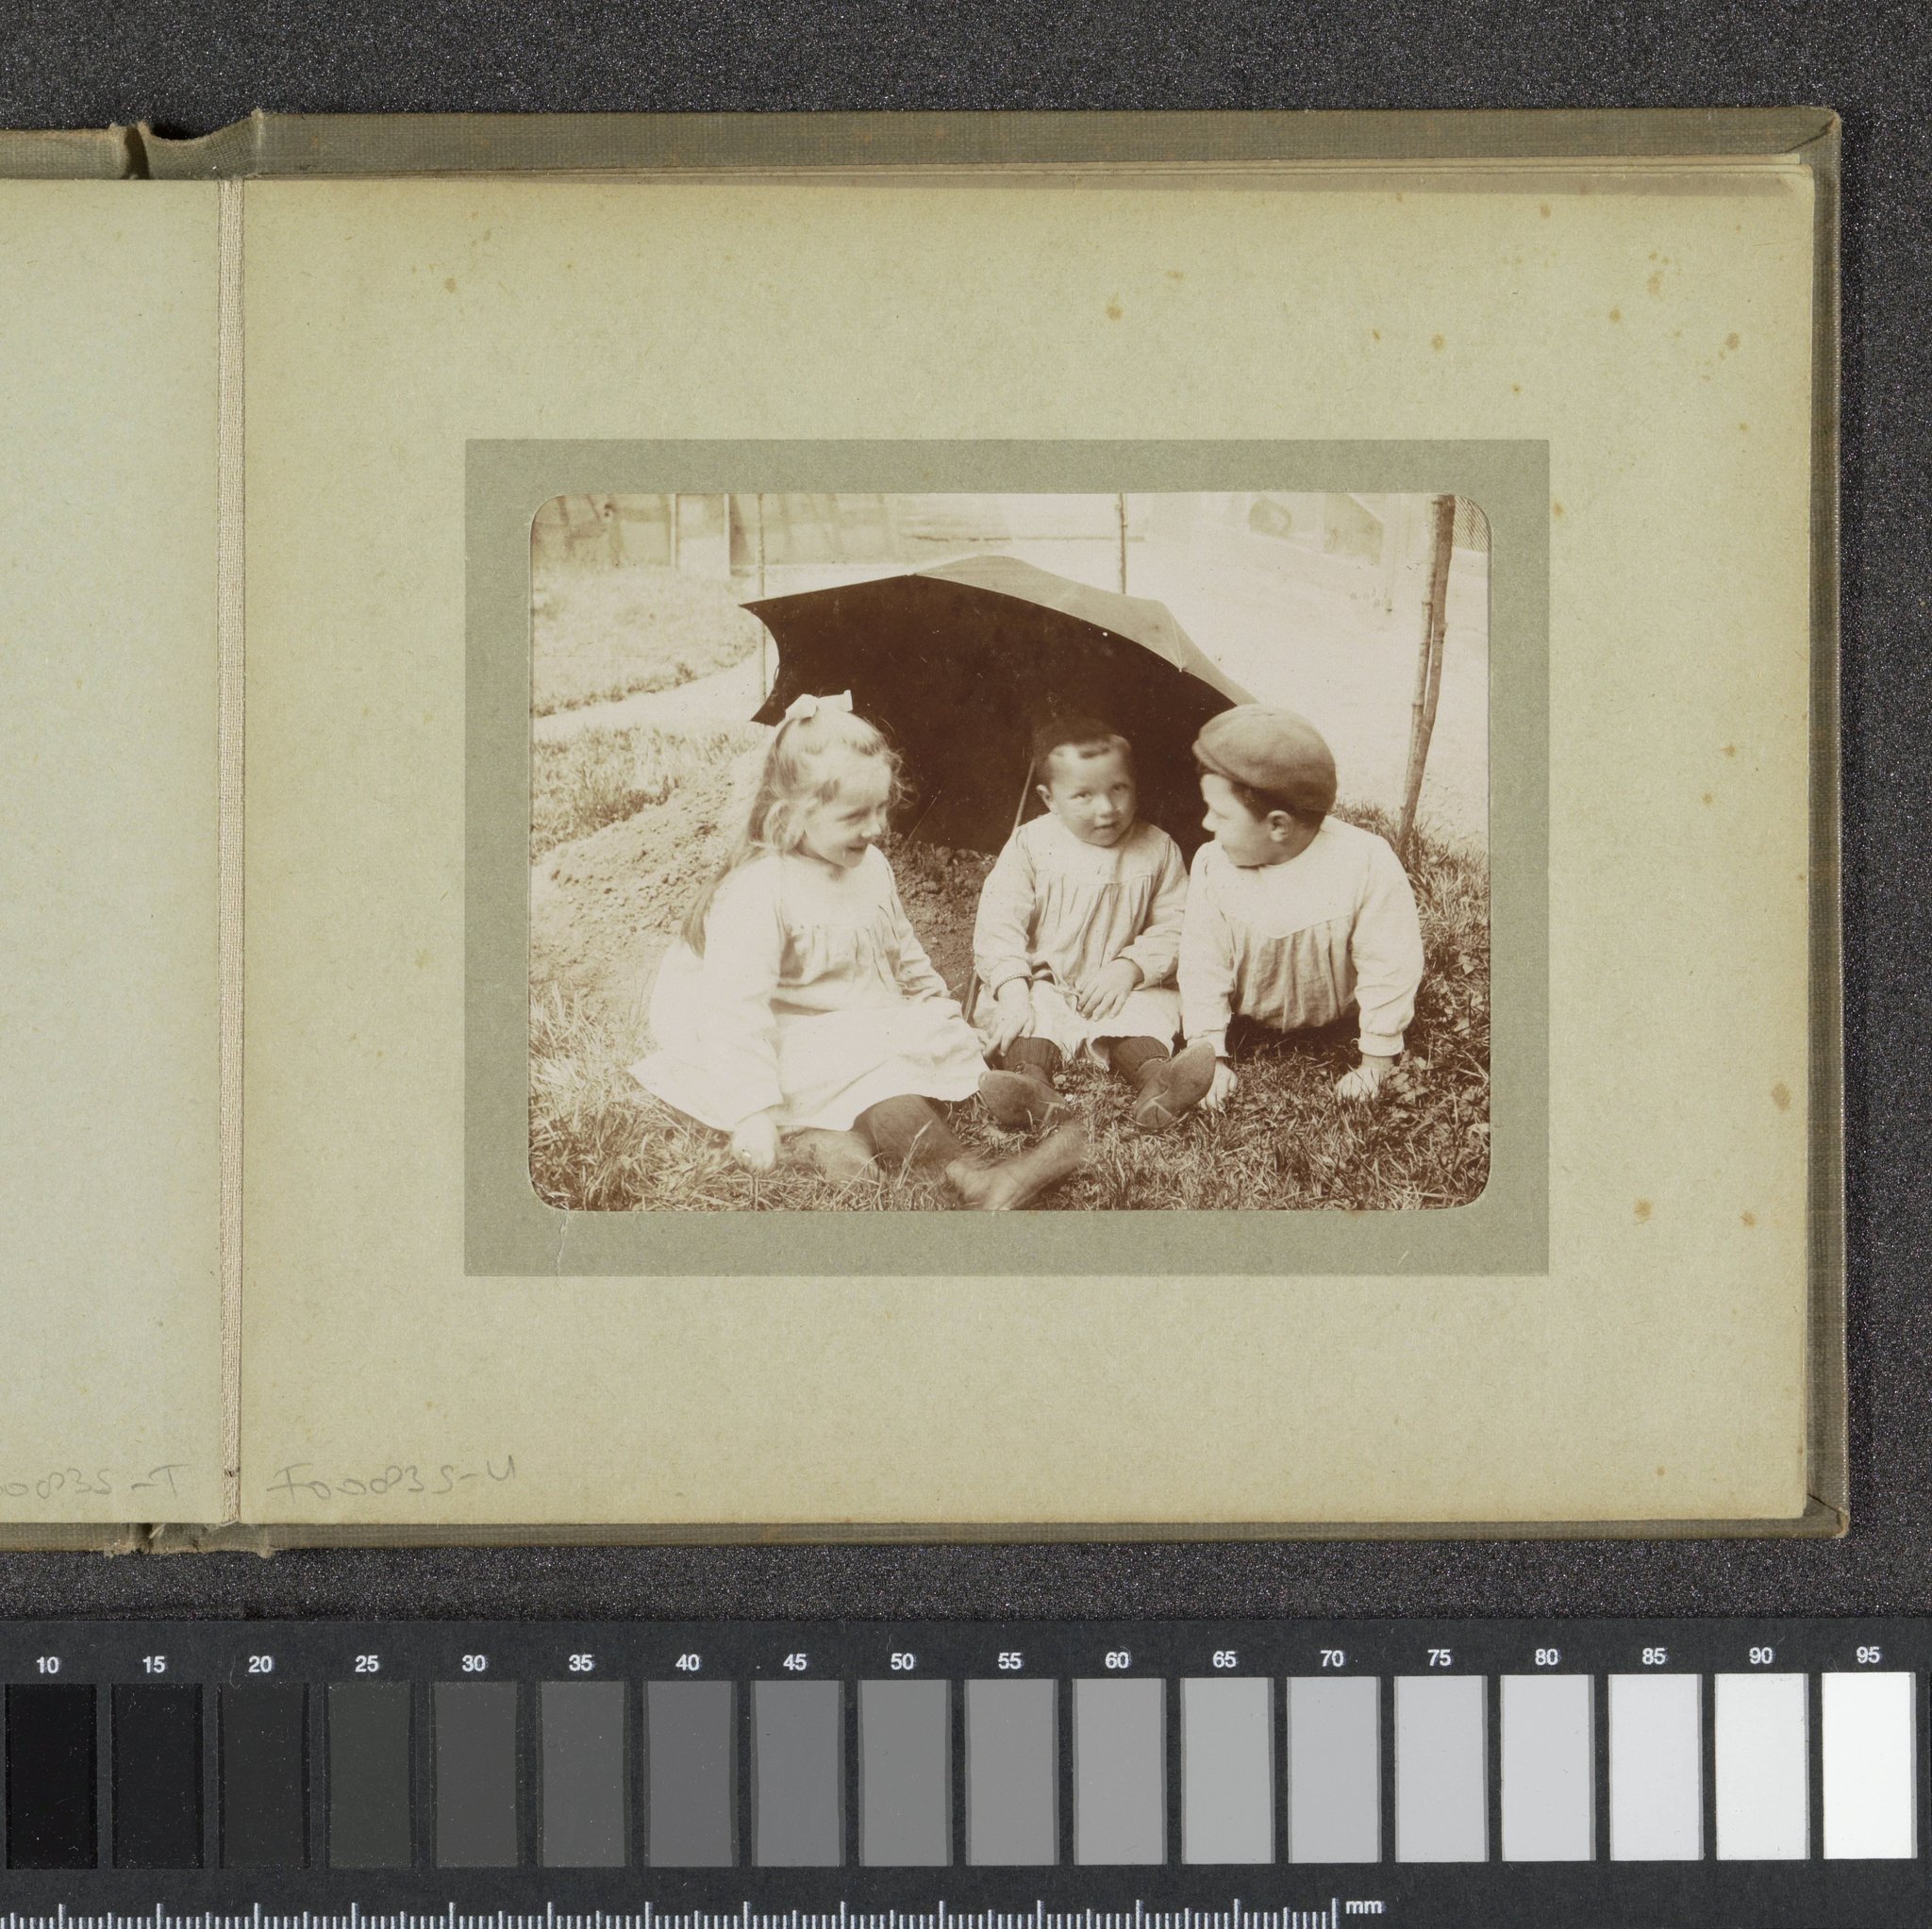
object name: photograph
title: Drie kleuters in een tuin zittend onder een paraplu, waarschijnlijk de tweeling Ad (rechts) en Johanna (links) en Han (midden) van der Kop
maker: willem carel van der kop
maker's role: amateurfotograaf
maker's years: 1869-1924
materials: cardboard, paper, photographic support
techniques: daylight paper print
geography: schoonhoven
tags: twins, family life, head-gear: cap, umbrella, tot, toddler ~ the ages of man, brothers or sisters (second degree family relationships)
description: Onderdeel van Fotoalbum met opnames van Ad, Johanna en Han van der Kop, hun moeder W.G. Hoogendijk en familieleden.